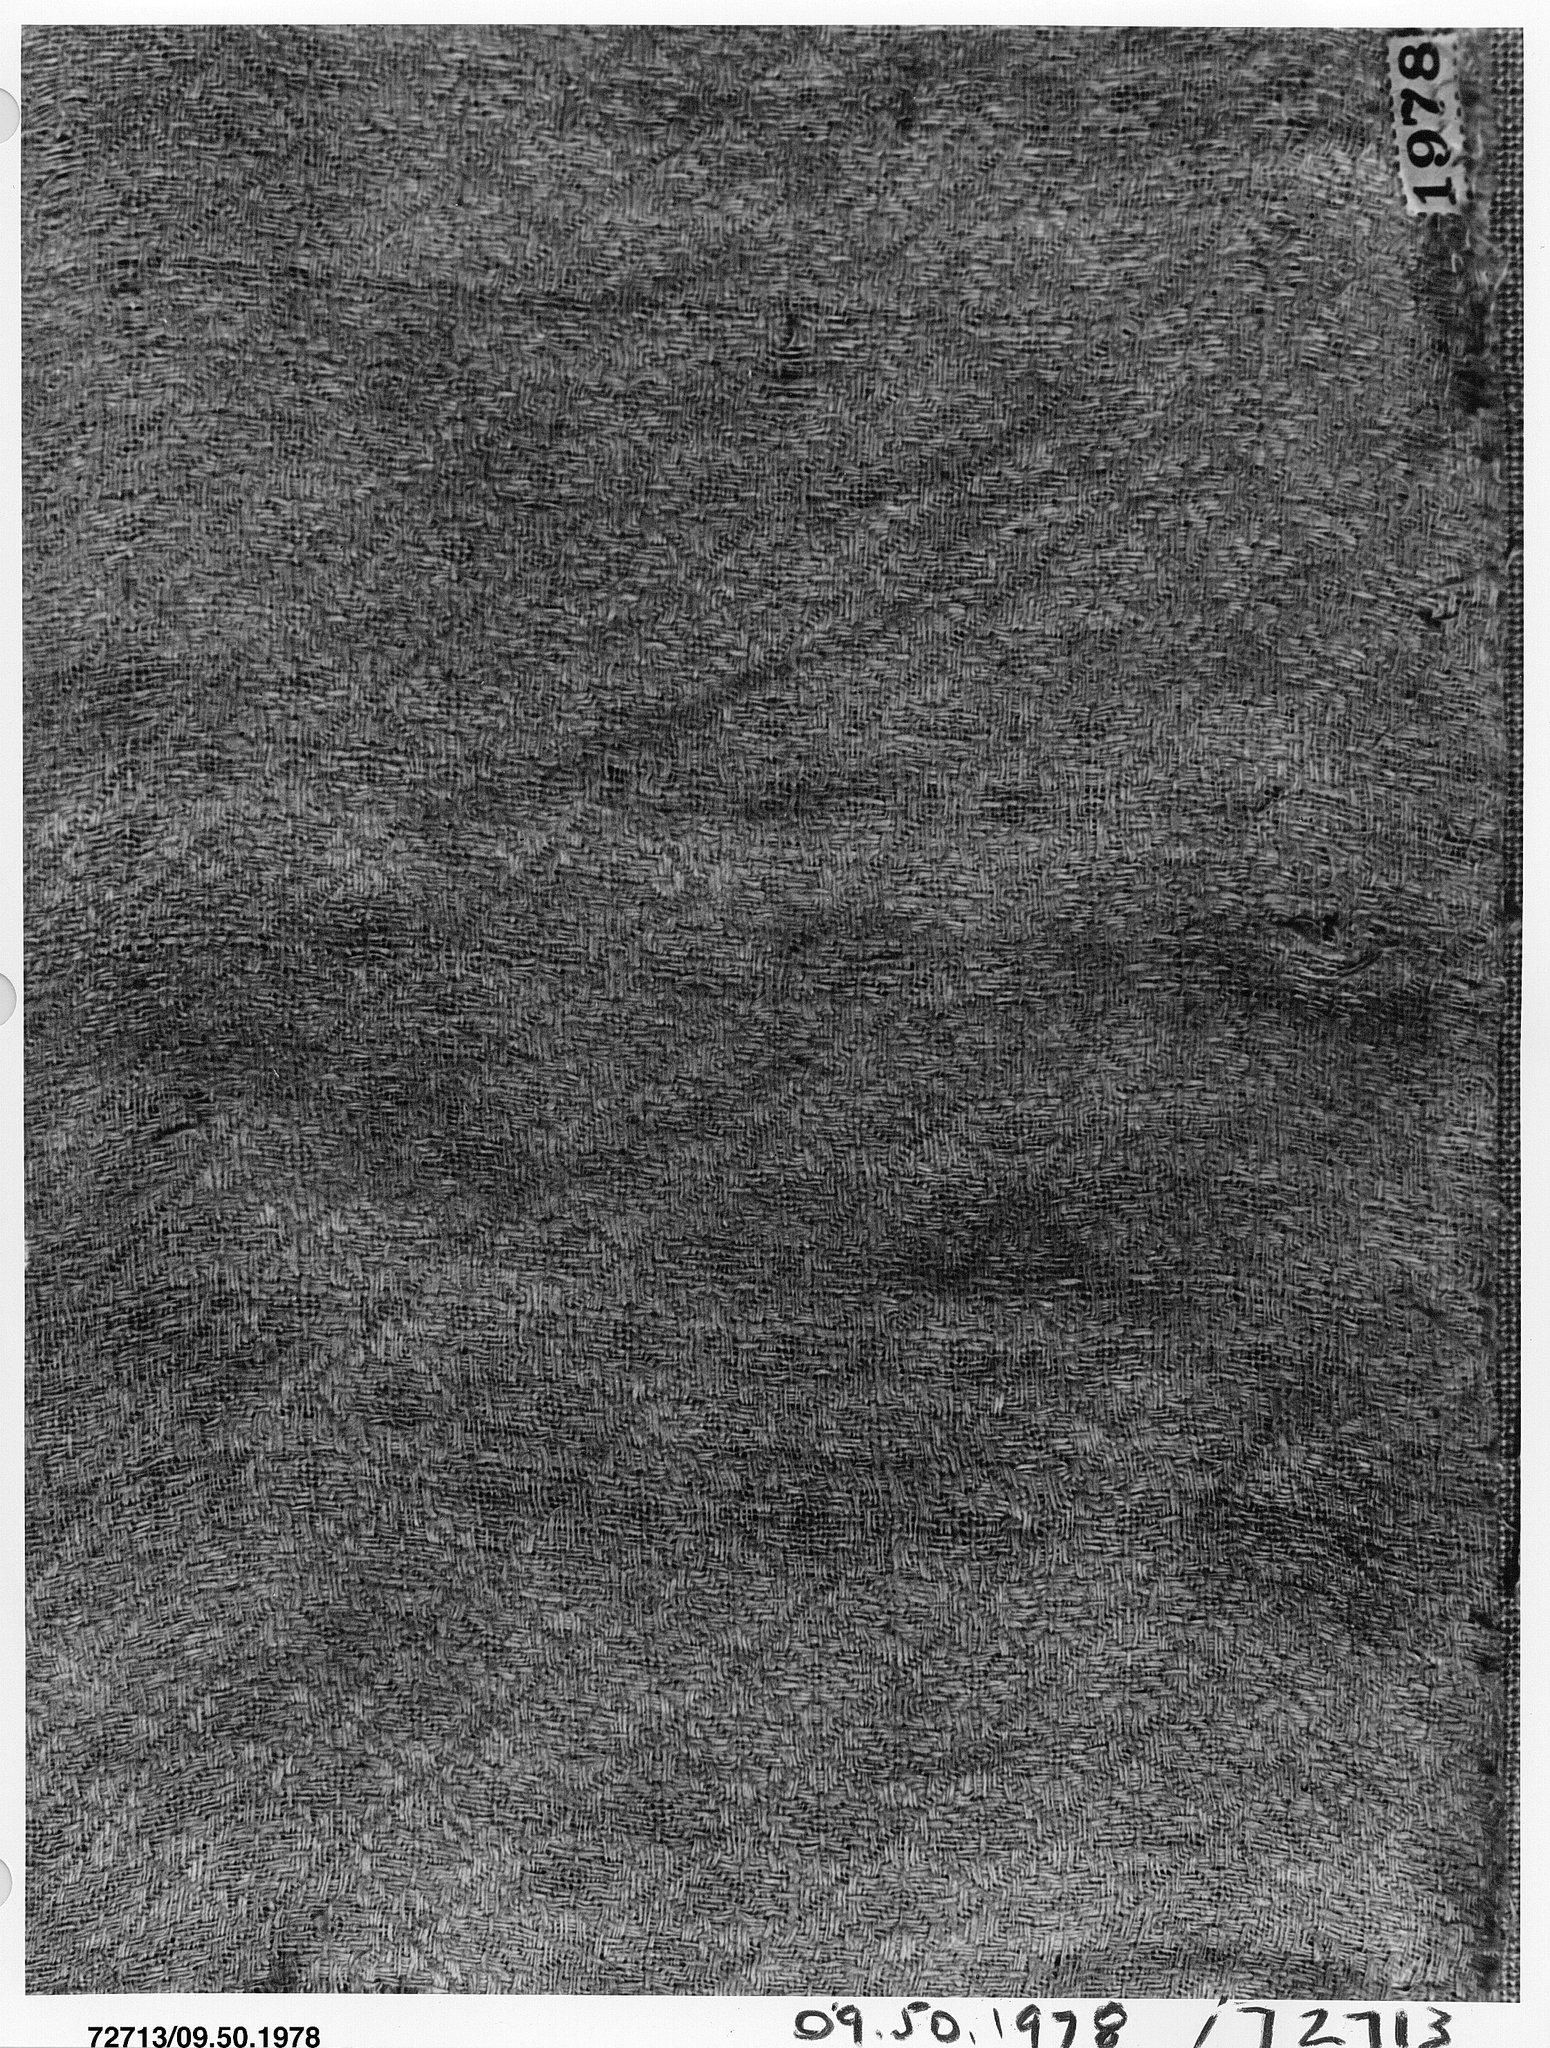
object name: piece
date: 1701-1900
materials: linen